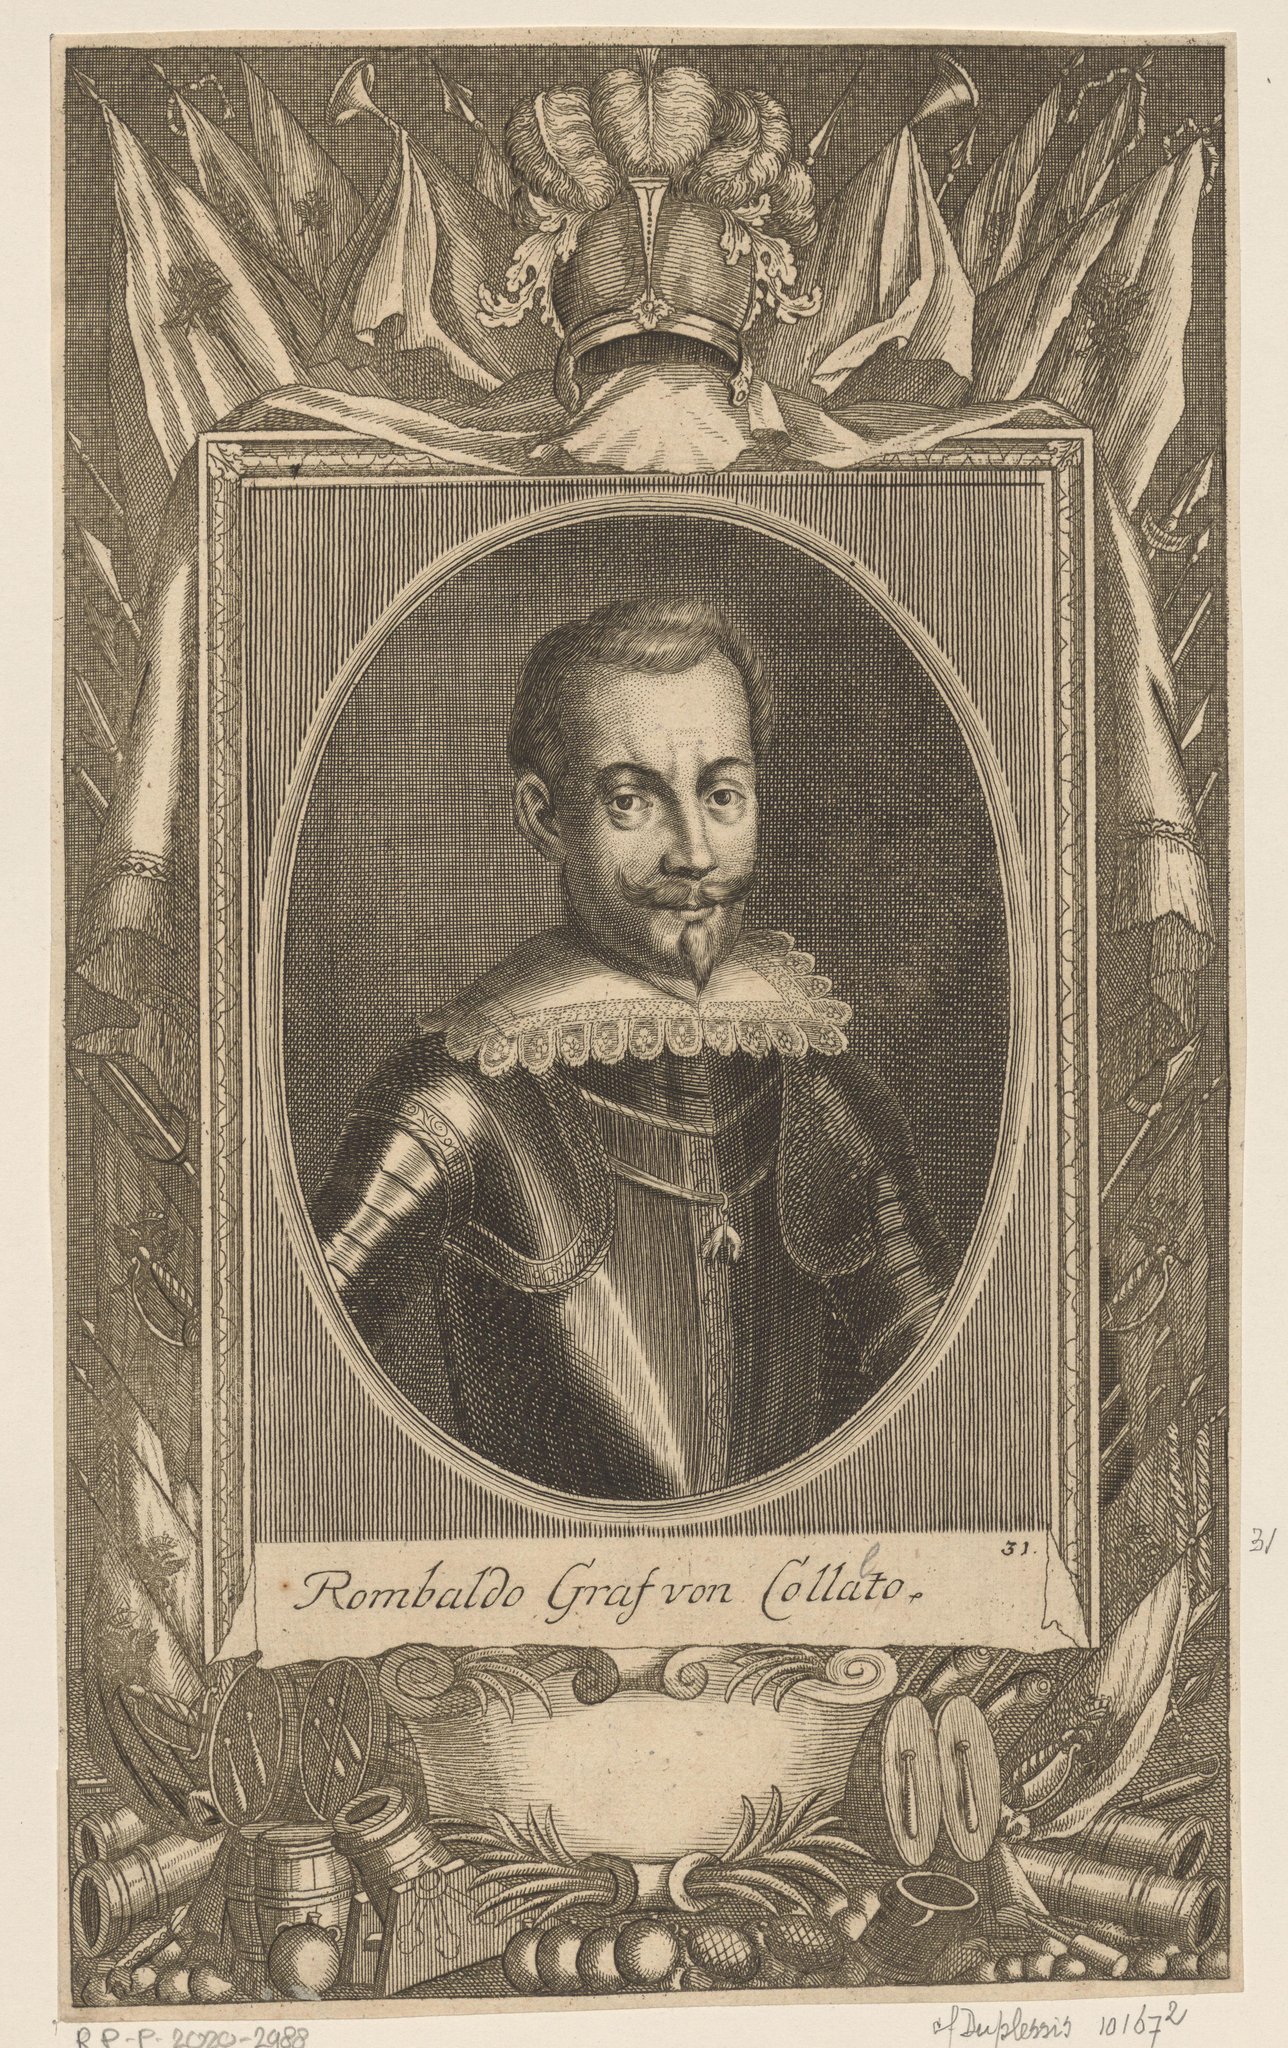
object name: print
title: Portret van Ramboldo van Collalto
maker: Anonymous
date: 1700-1749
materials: paper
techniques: engraving, etching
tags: historical persons